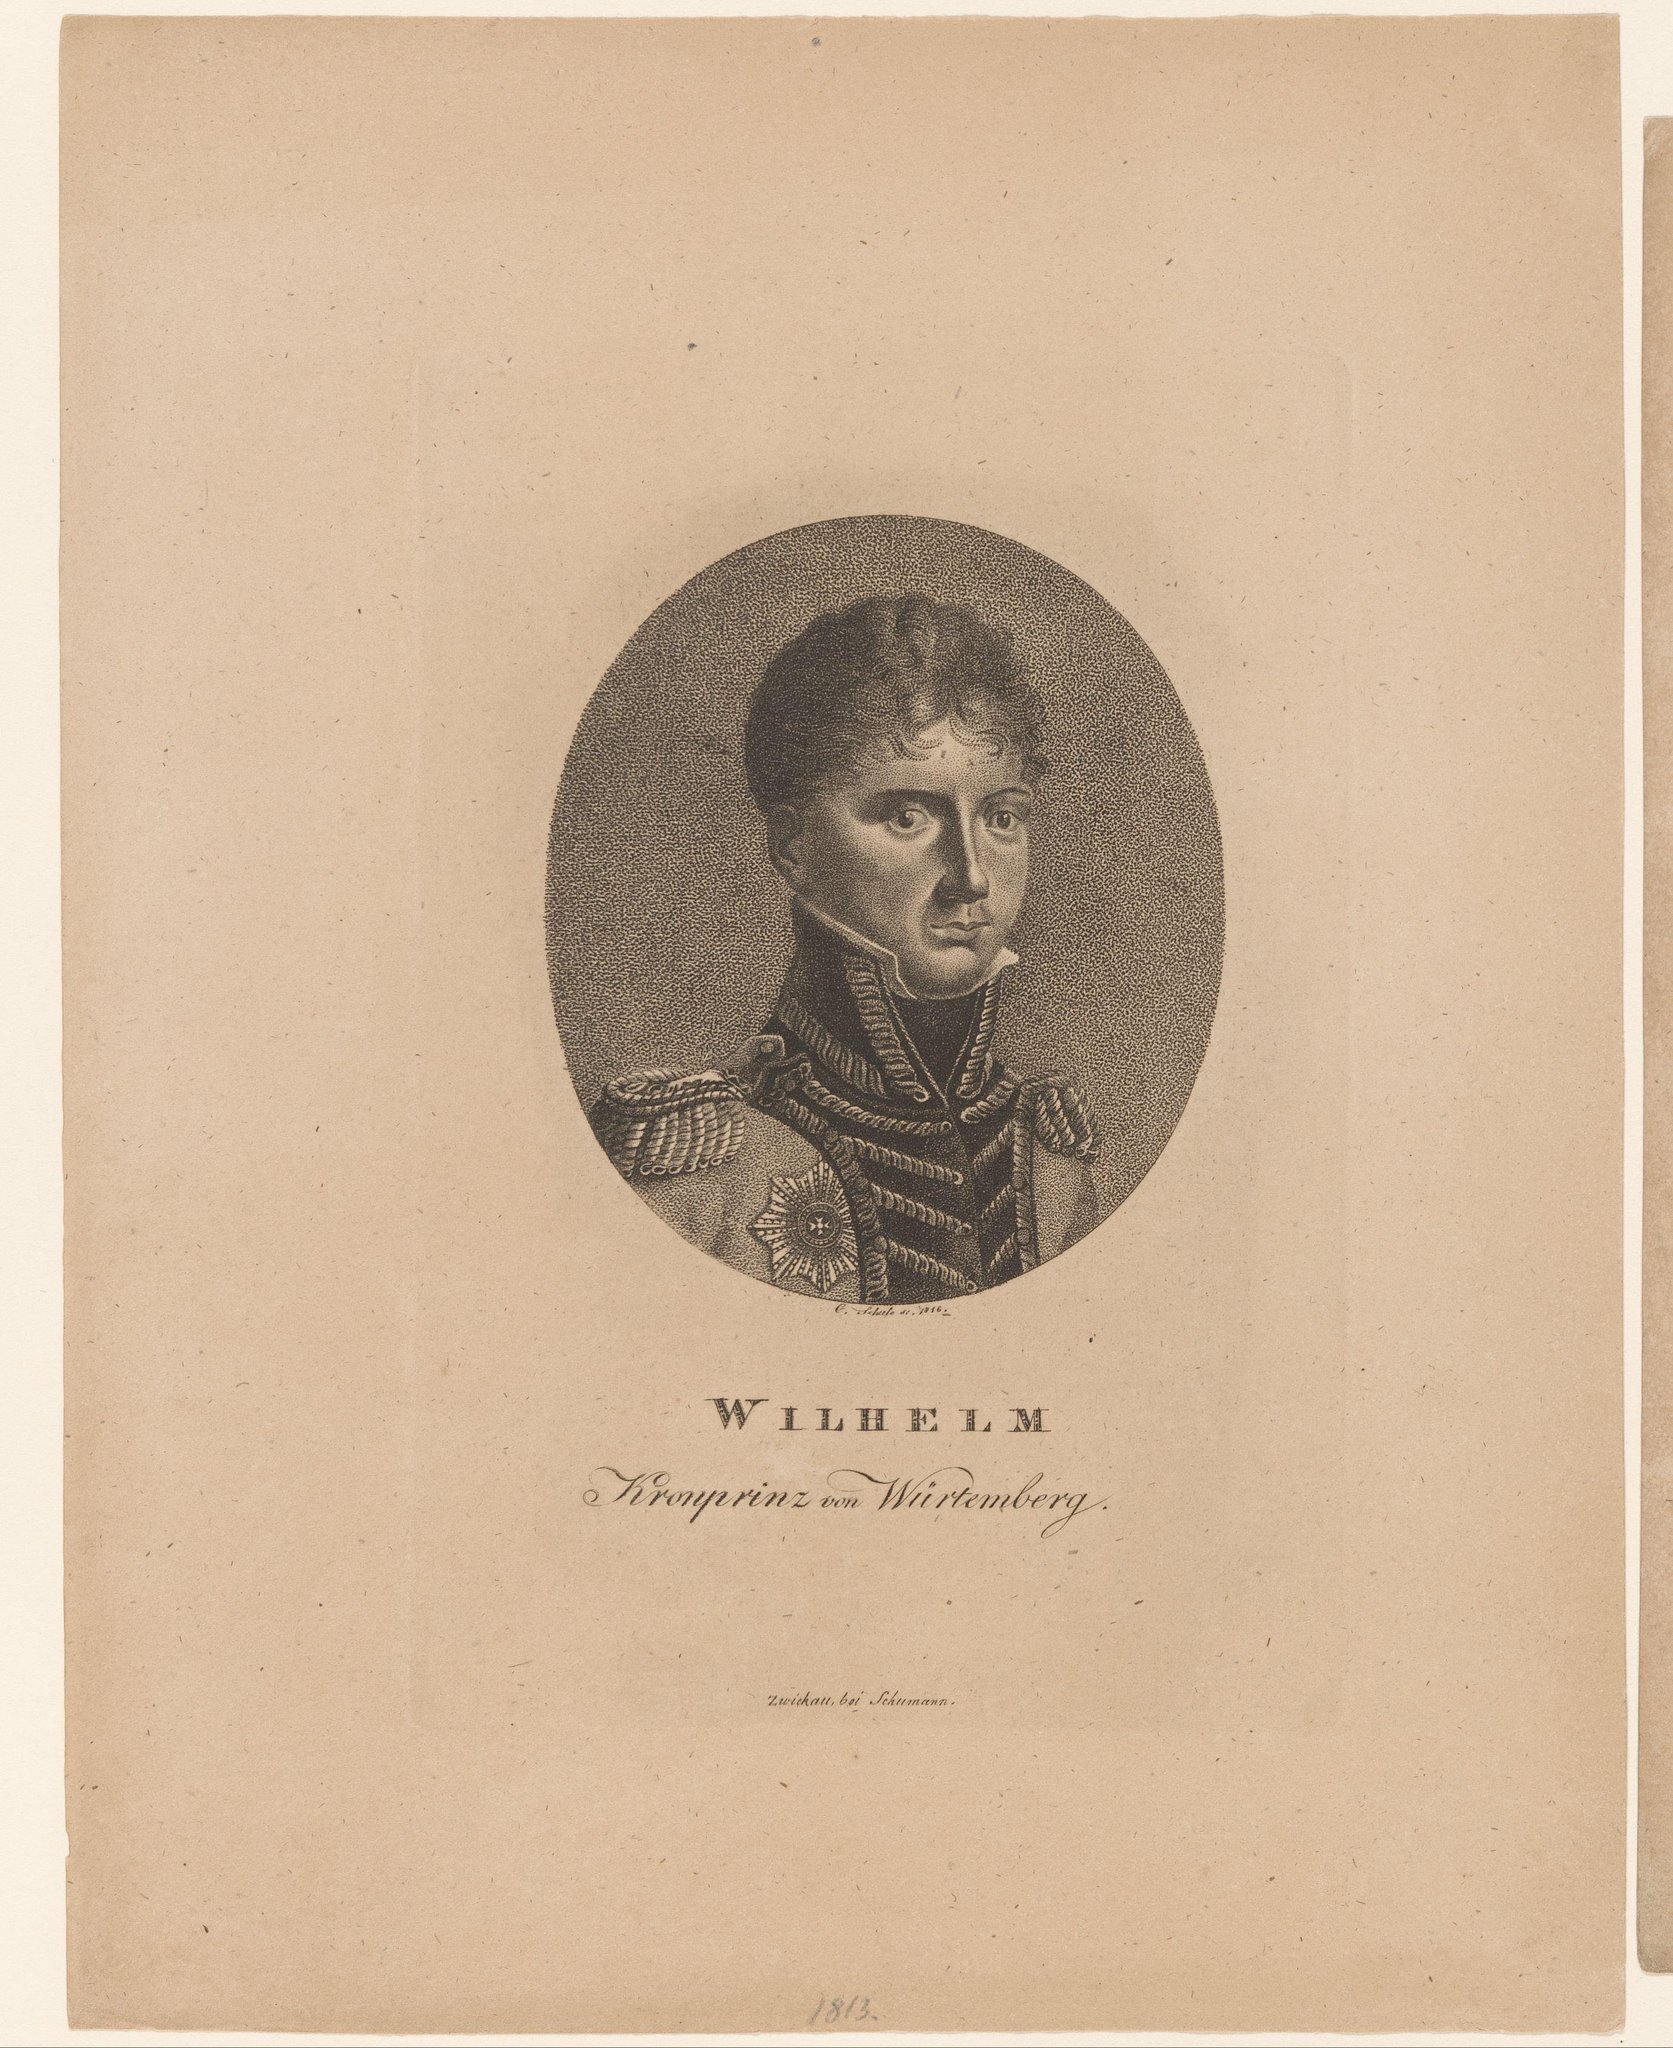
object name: print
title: Wilhelm Kronprinz von Würtemberg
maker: christian schule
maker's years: 1764-1816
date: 1816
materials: paper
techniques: etching, engraving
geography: zwickau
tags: willem i koning van württemberg, historical persons, king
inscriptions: collector's mark: Lugt 2228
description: Portret van kroonprins Willem I van Württemberg.